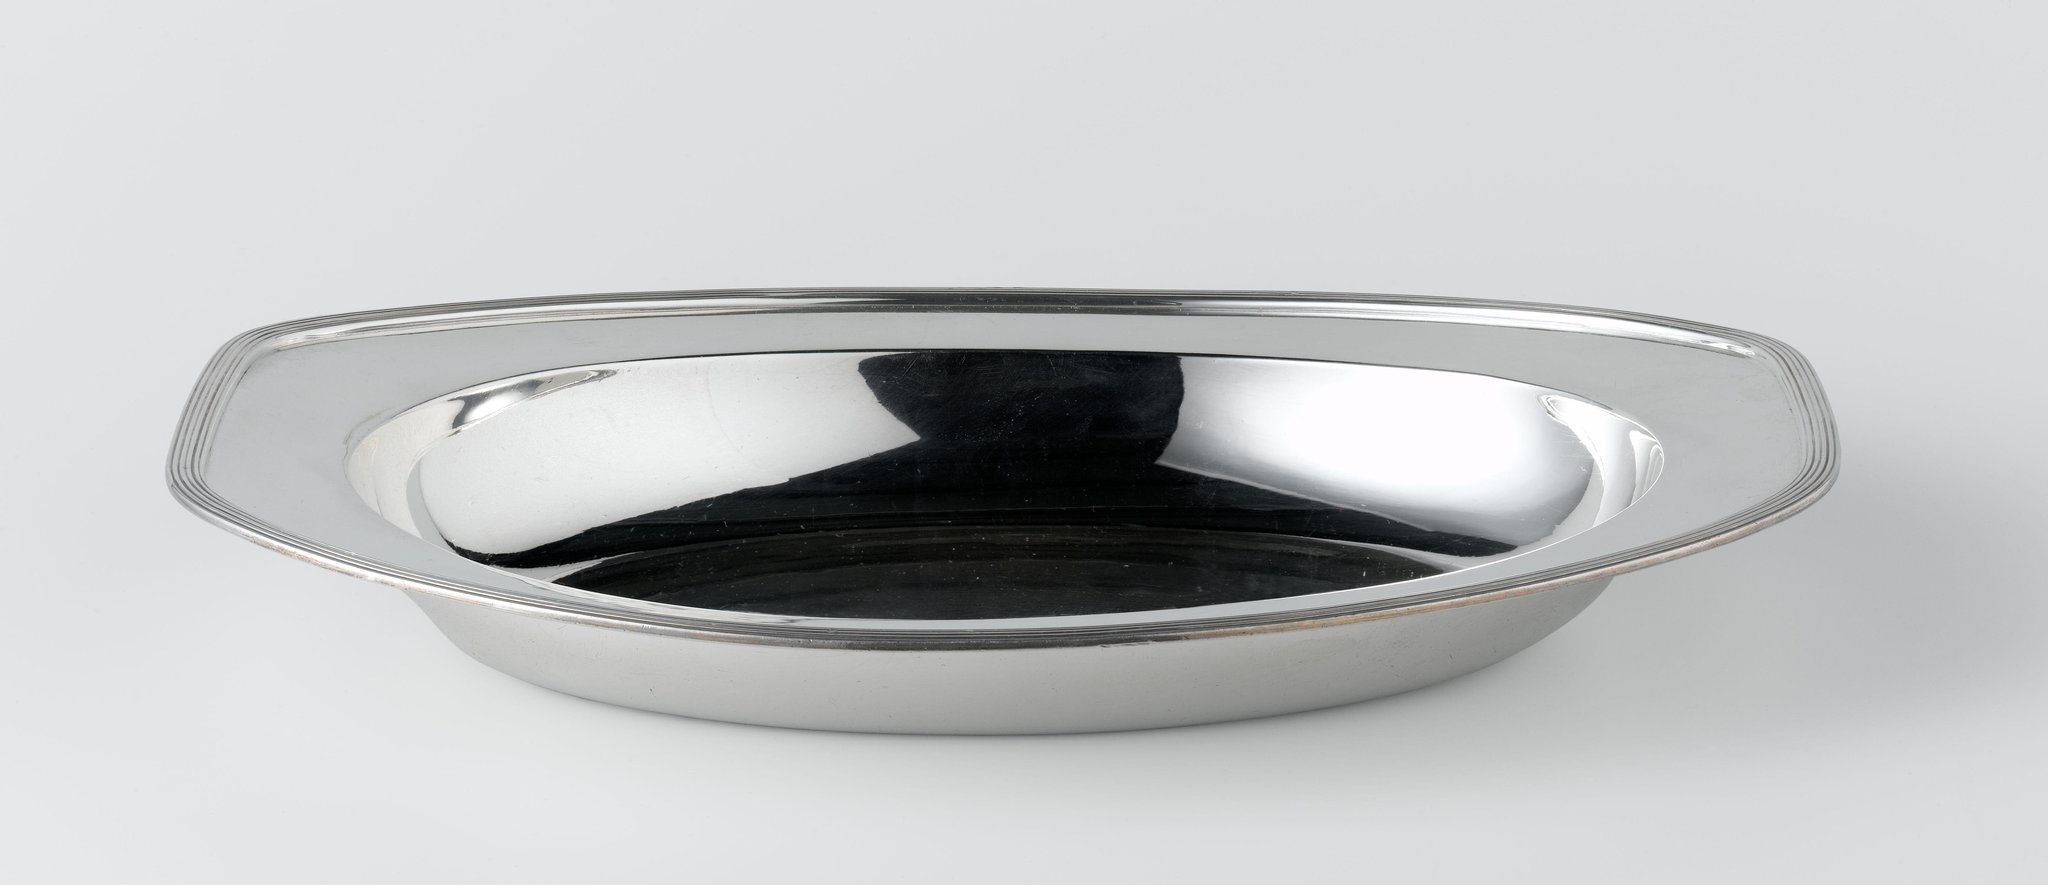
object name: vessel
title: Dekschaal, behorend bij komfoor, gedecoreerd met filetranden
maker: jacob hendrik stellingwerff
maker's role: silversmith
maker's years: 1773-1823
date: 1816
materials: silver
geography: amsterdam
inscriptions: date letter: ‘G’, retailer's mark: ‘BENNEWITZ BONEBAKKER’, assay office mark, alloy mark, assayer's mark: ‘S1 in ovaal’, duty mark: ‘I’, maker's mark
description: De schaal heeft een rechthoekige, brede, vlakke rand met afgeronde hoeken, die is versierd met een filetrand.